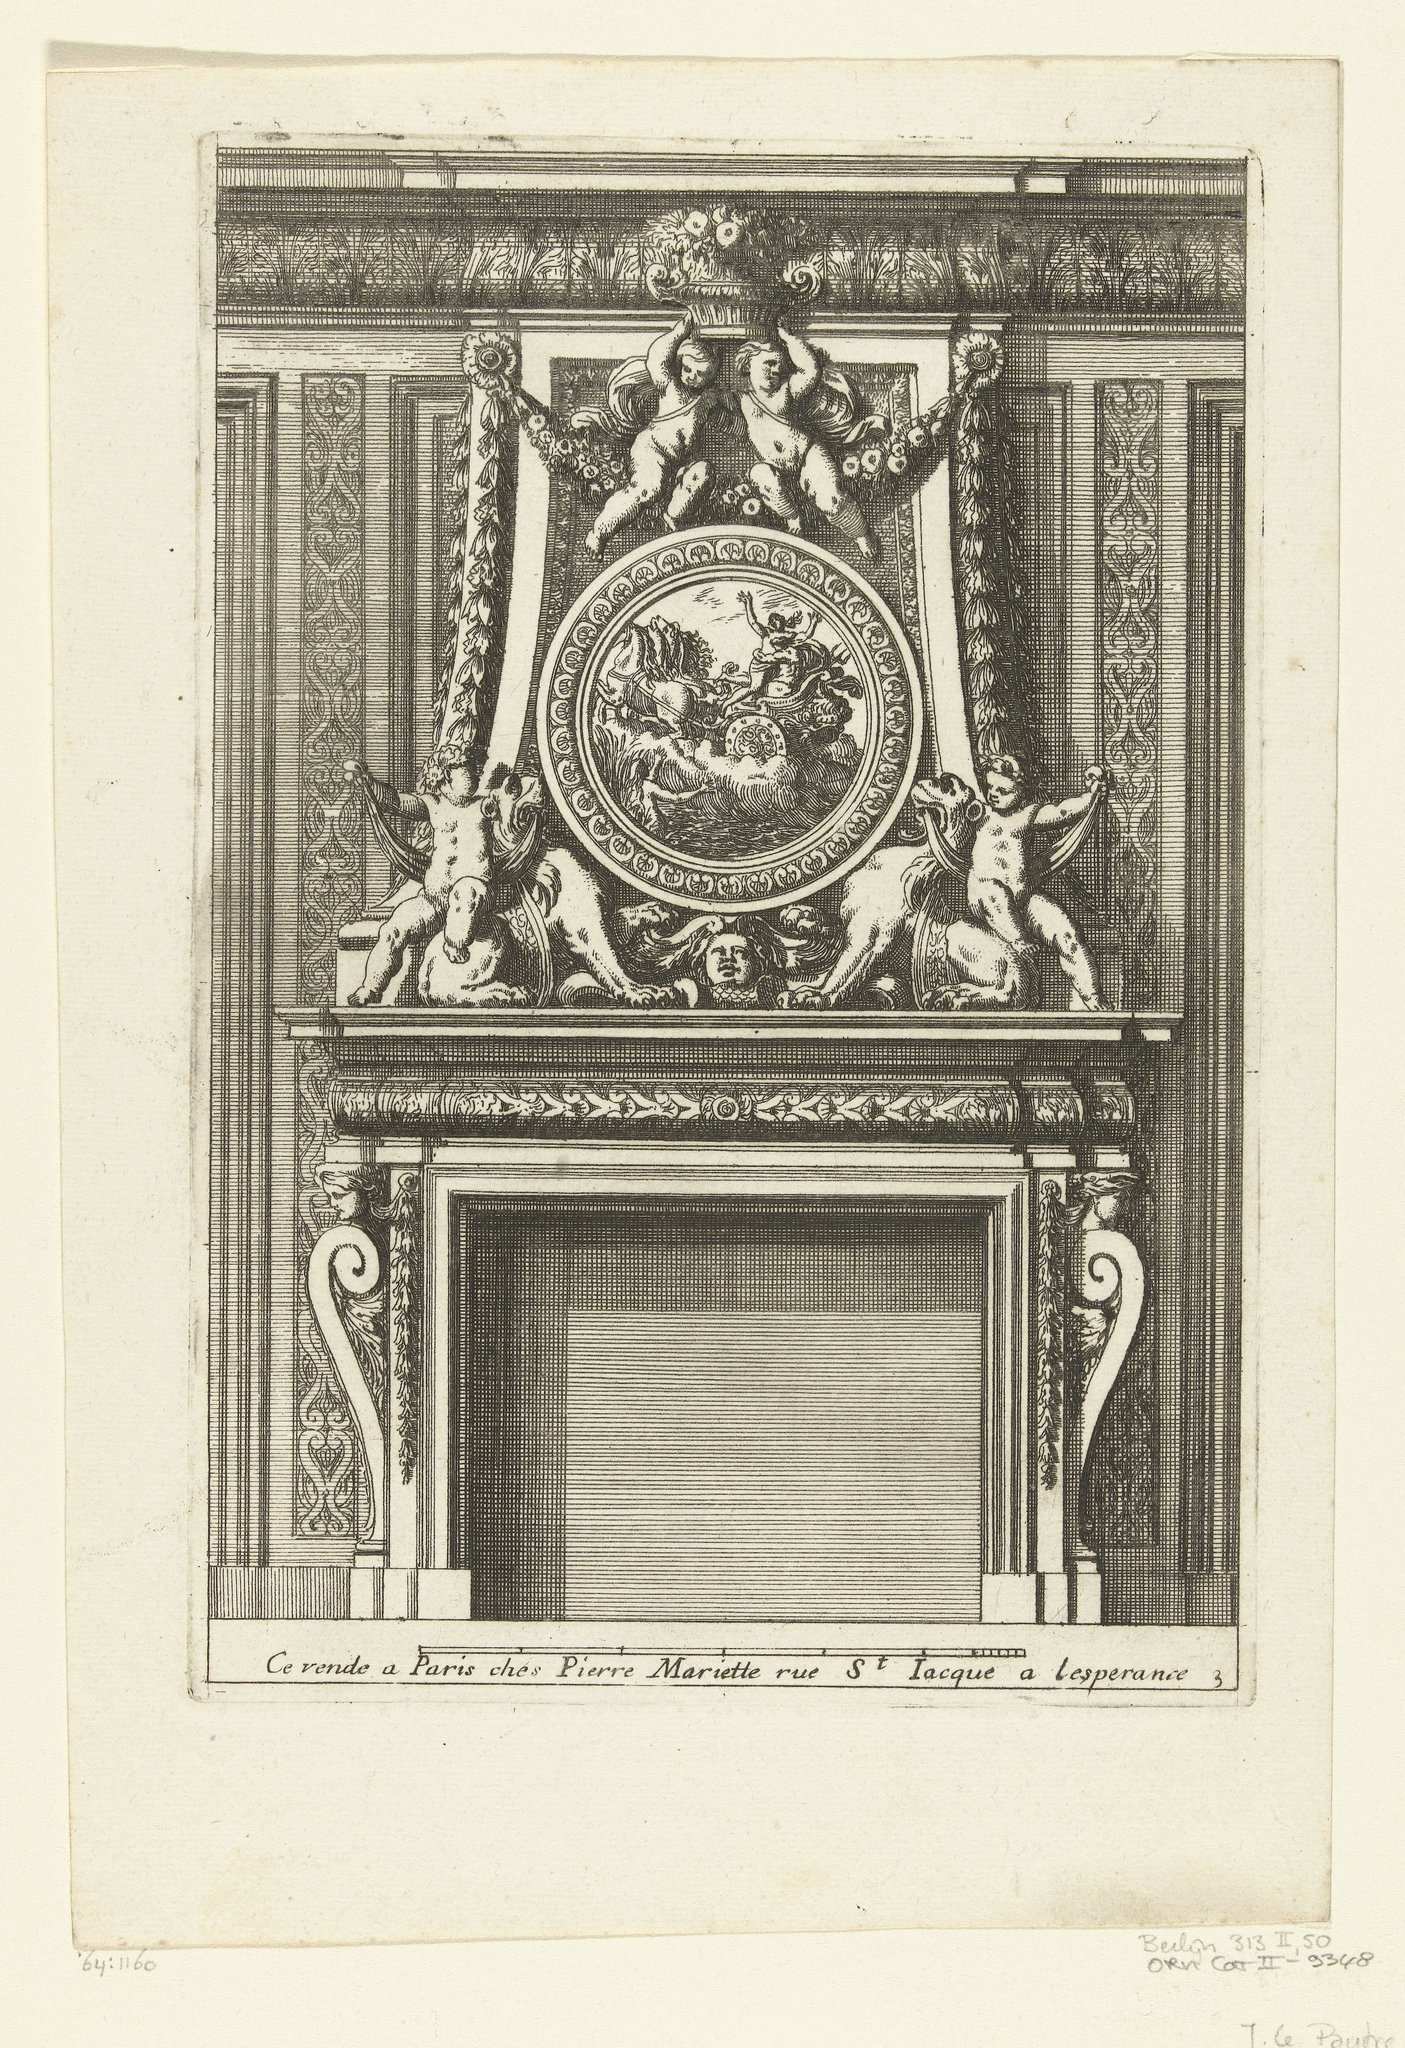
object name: ornament print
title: Onderboezem met medaillon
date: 1658-1670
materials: paper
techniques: etching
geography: france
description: Medaillon met de Ontvoering van Proserpina, aan weerskanten zit een putto op een leeuw.